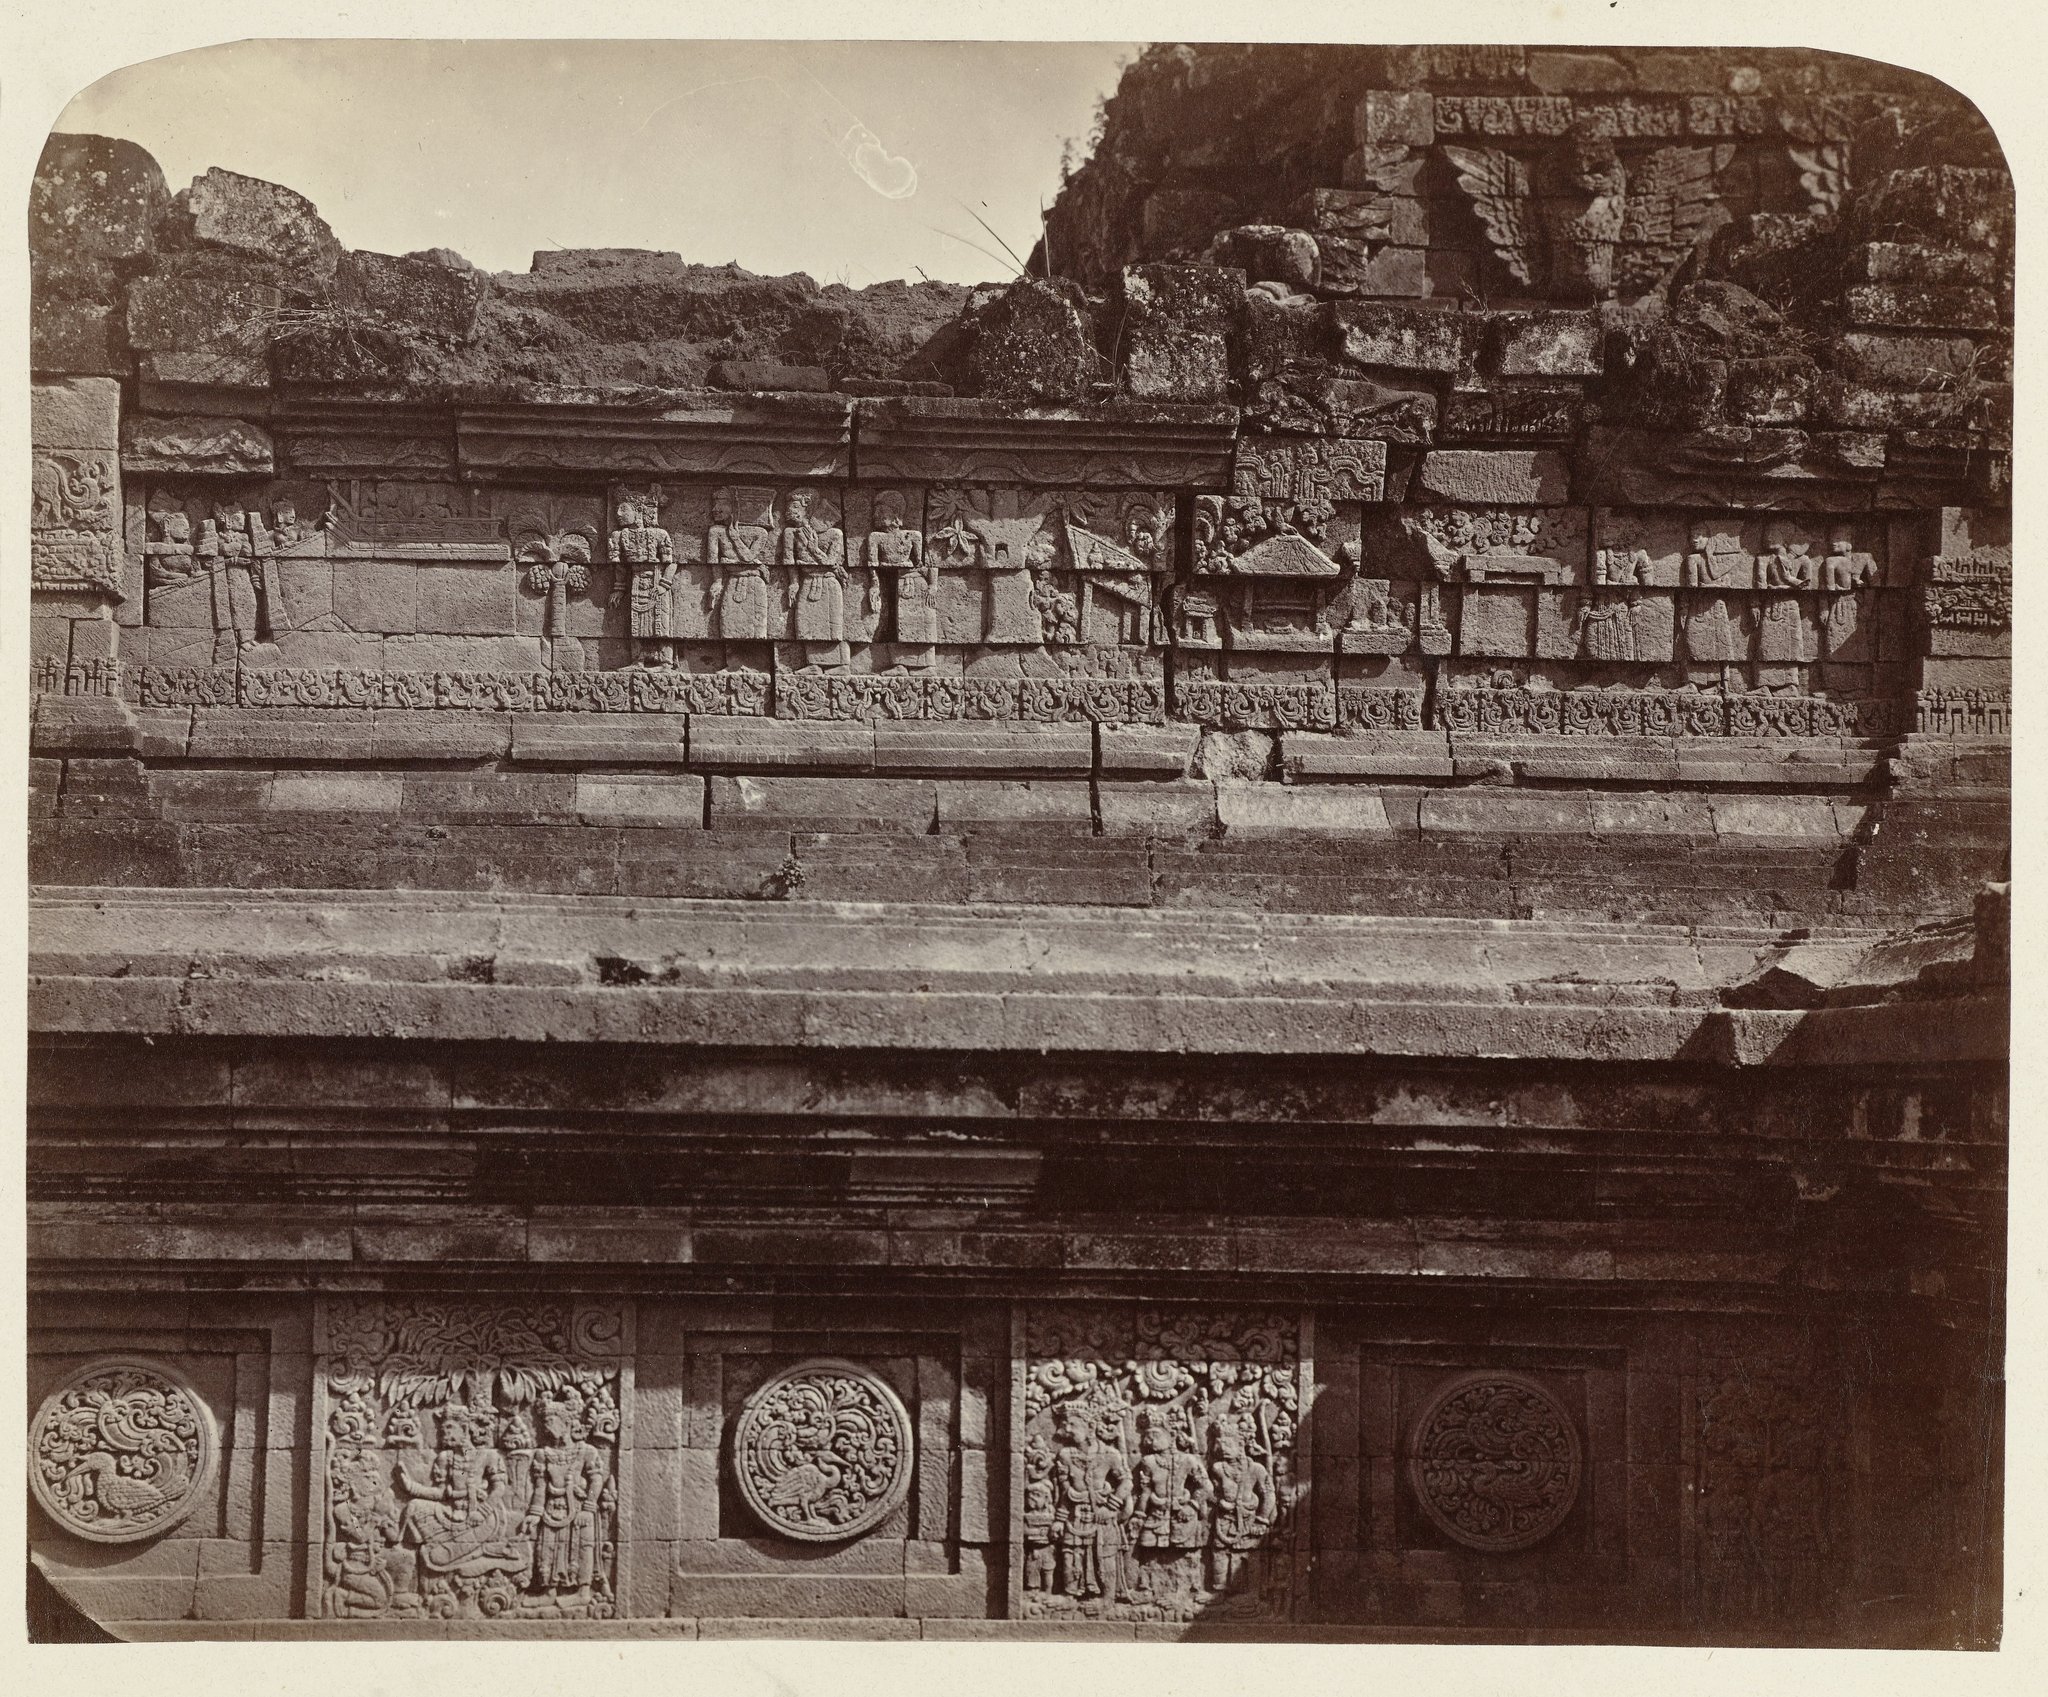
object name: photograph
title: Basreliëf van den tempel (noordzijde) 1e gaanderij. Panataran (r. Kediri)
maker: isidore kinsbergen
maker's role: fotograaf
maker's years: 1821-1905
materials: cardboard, paper, photographic support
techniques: albumen print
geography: java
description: Candi Panataran (Temple Complex), main Temple; Krishnayana relief no 10 (Jarasamdha and Suniti come to meet Rukmini after which a female messenger has a meeting with Krishna), second narrative register north side. Panataran, Blitar district, East Java province 1323-1347 AD.